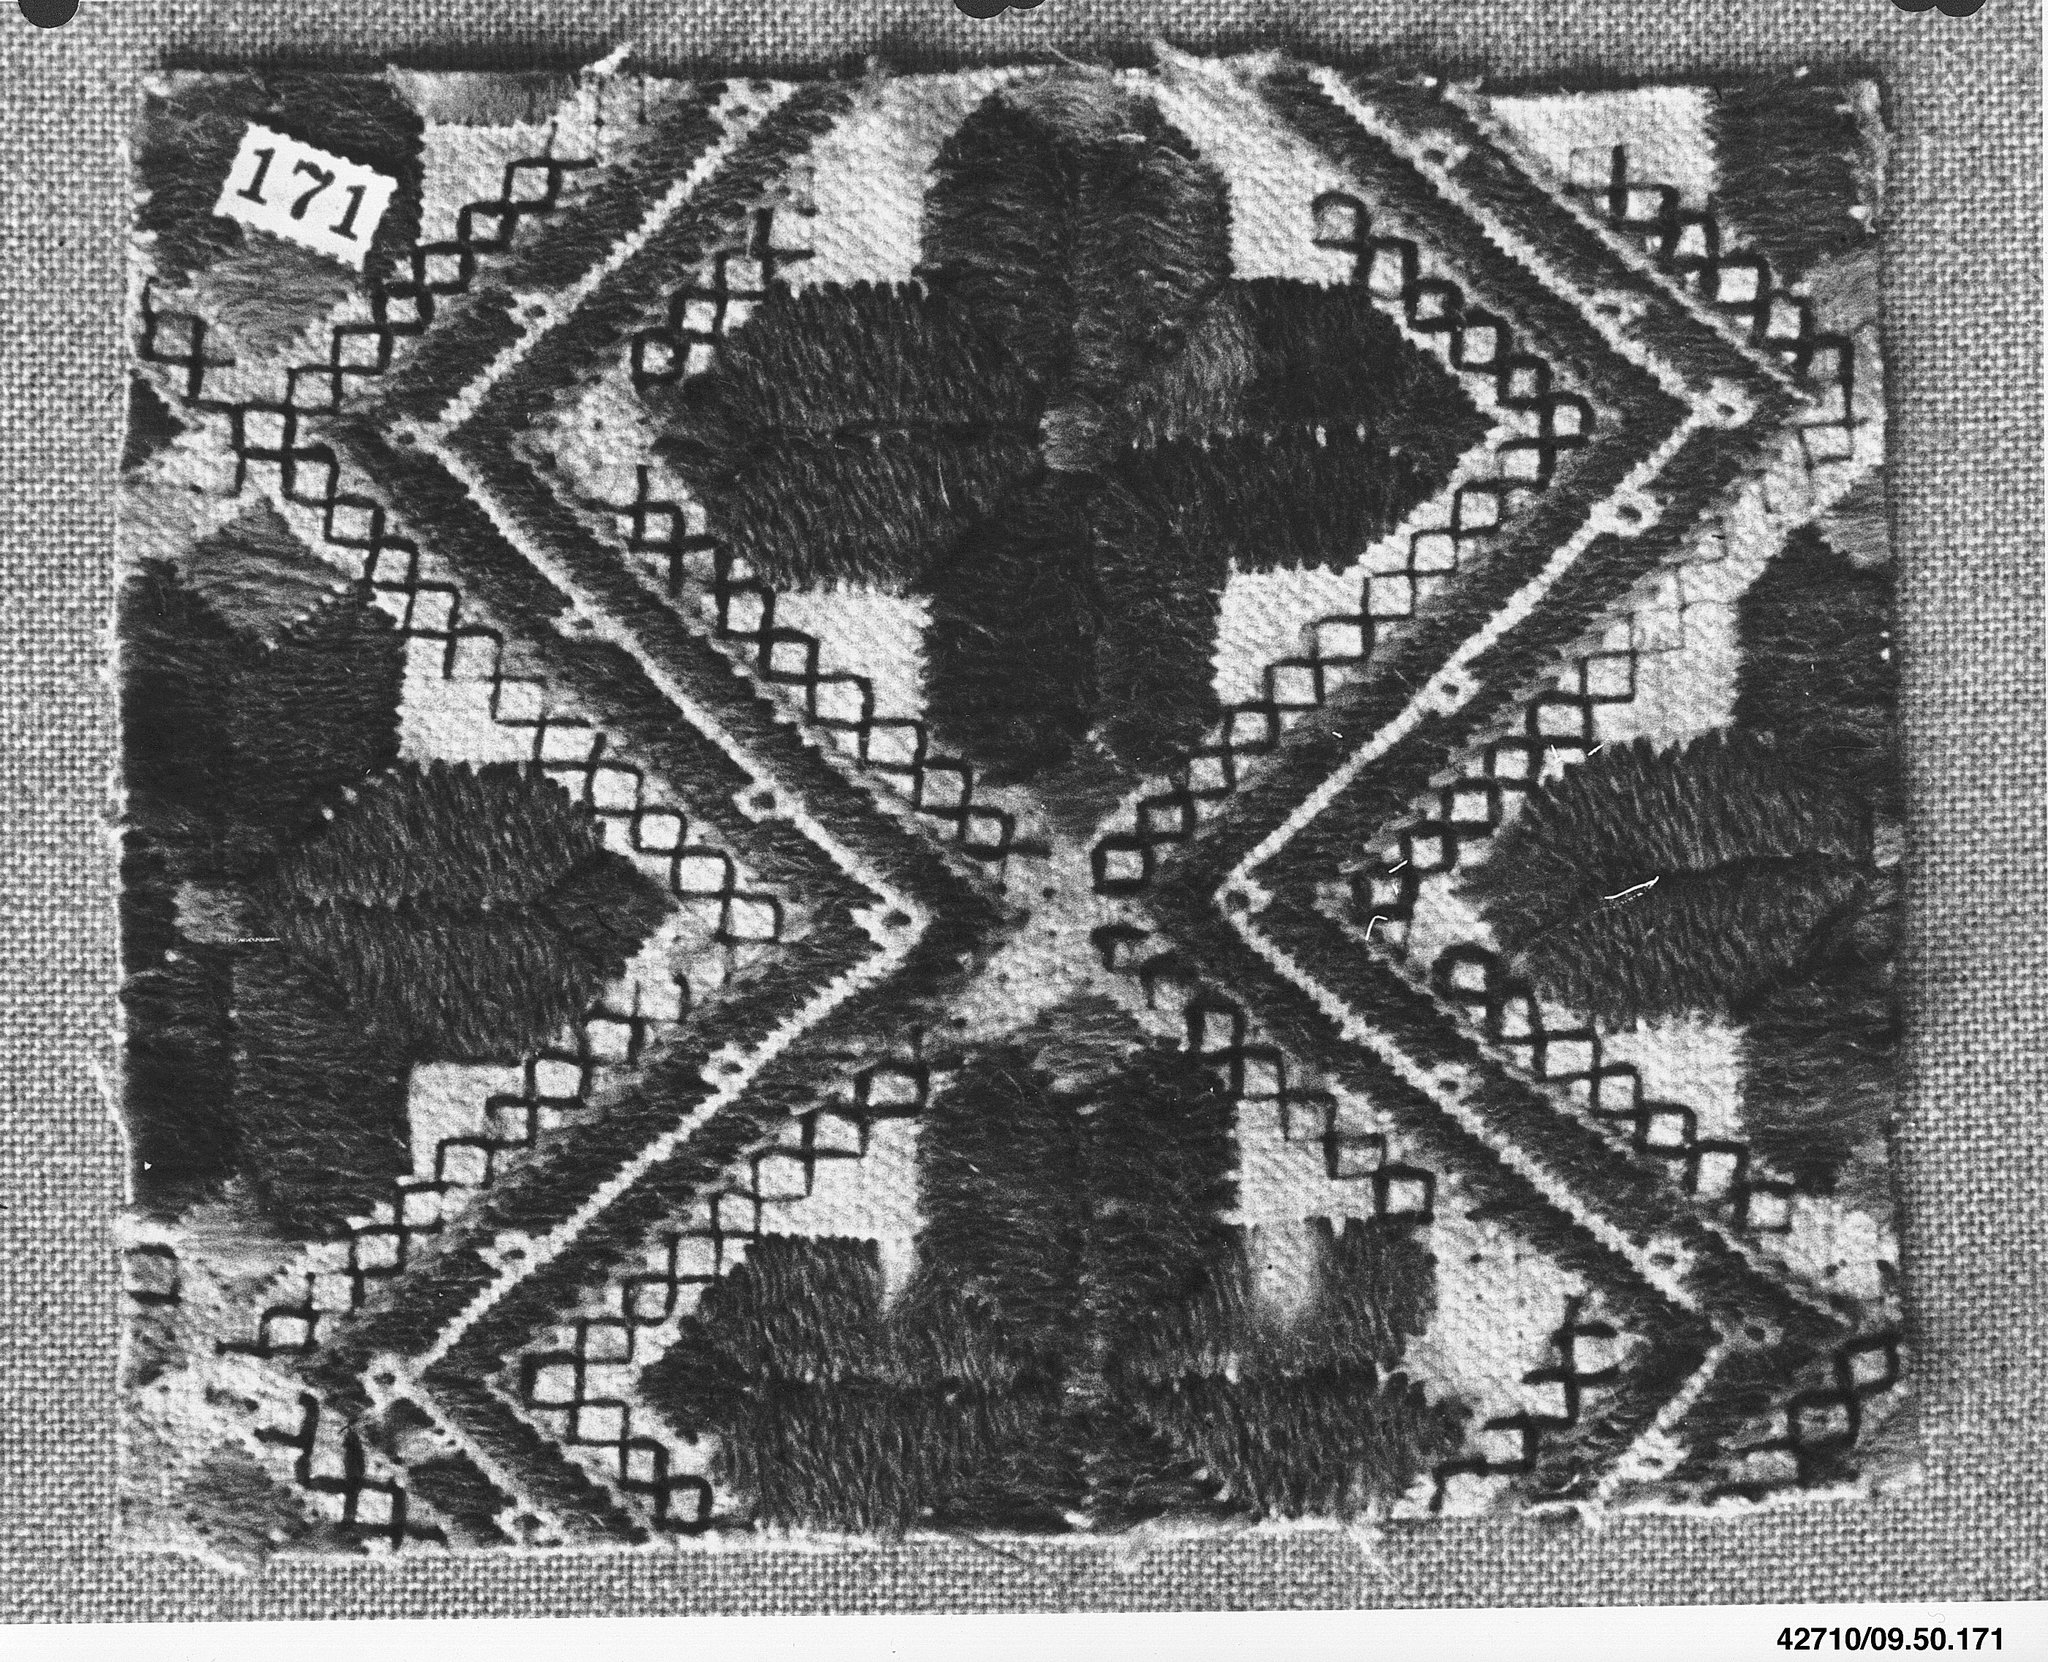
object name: costume fragment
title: Peasant costume fragment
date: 1701-1900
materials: canvas, wool